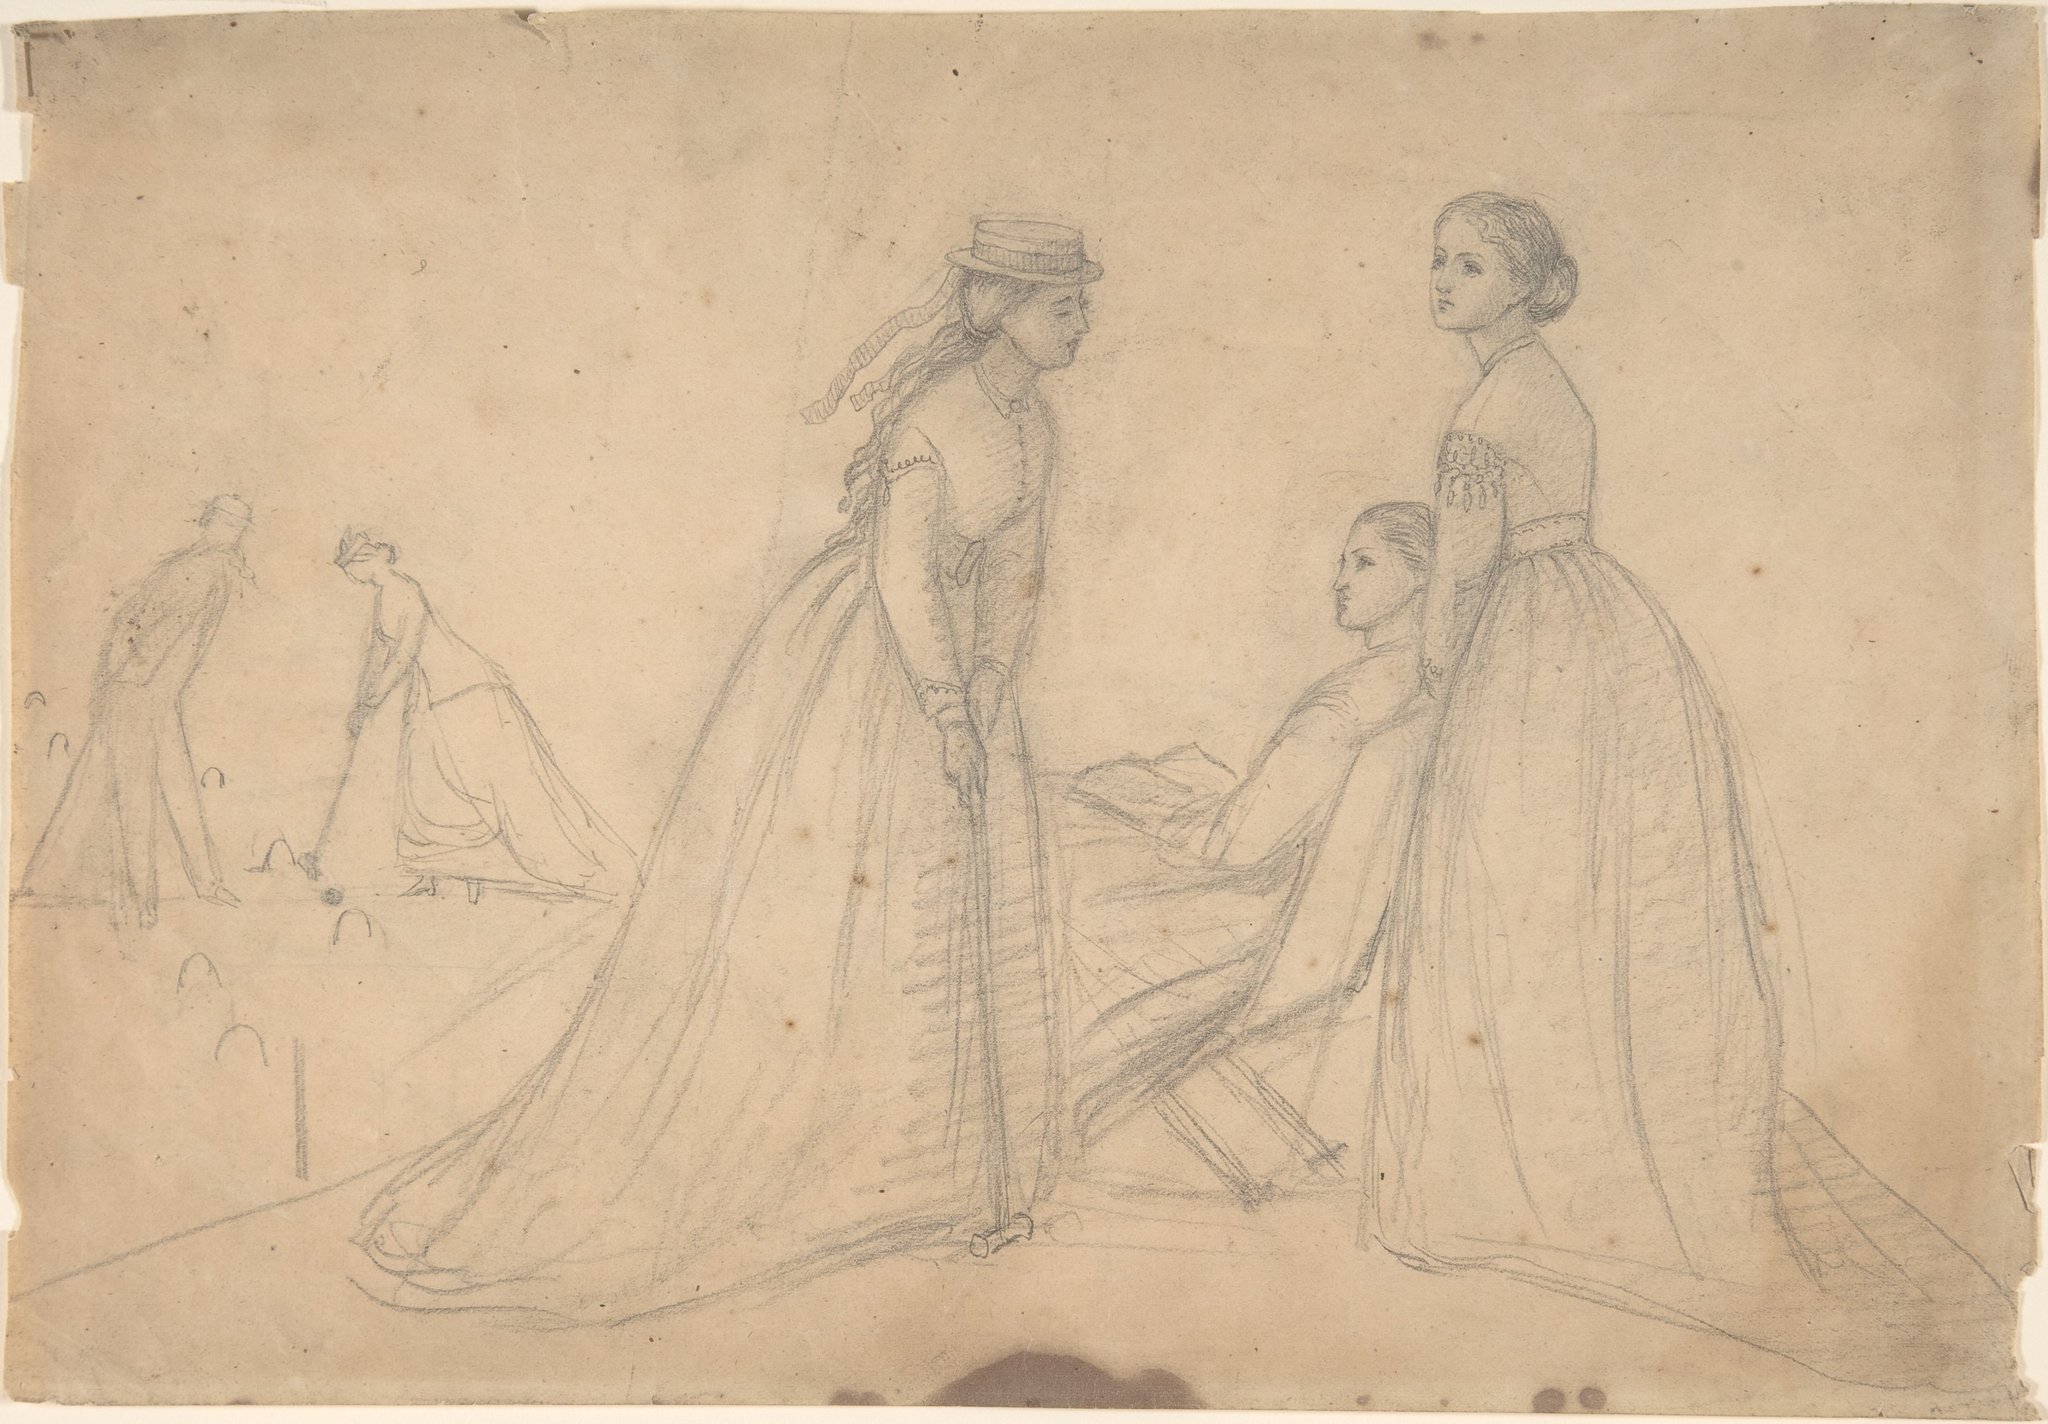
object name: drawing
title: Three women in conversation beside a croquet field (recto); Studies of a ballet dancer, a woman's profile, and a seated woman (verso)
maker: louisa starr canziani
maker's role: artist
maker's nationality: british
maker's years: 1845-1909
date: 1865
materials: graphite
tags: women,dancers,ballet